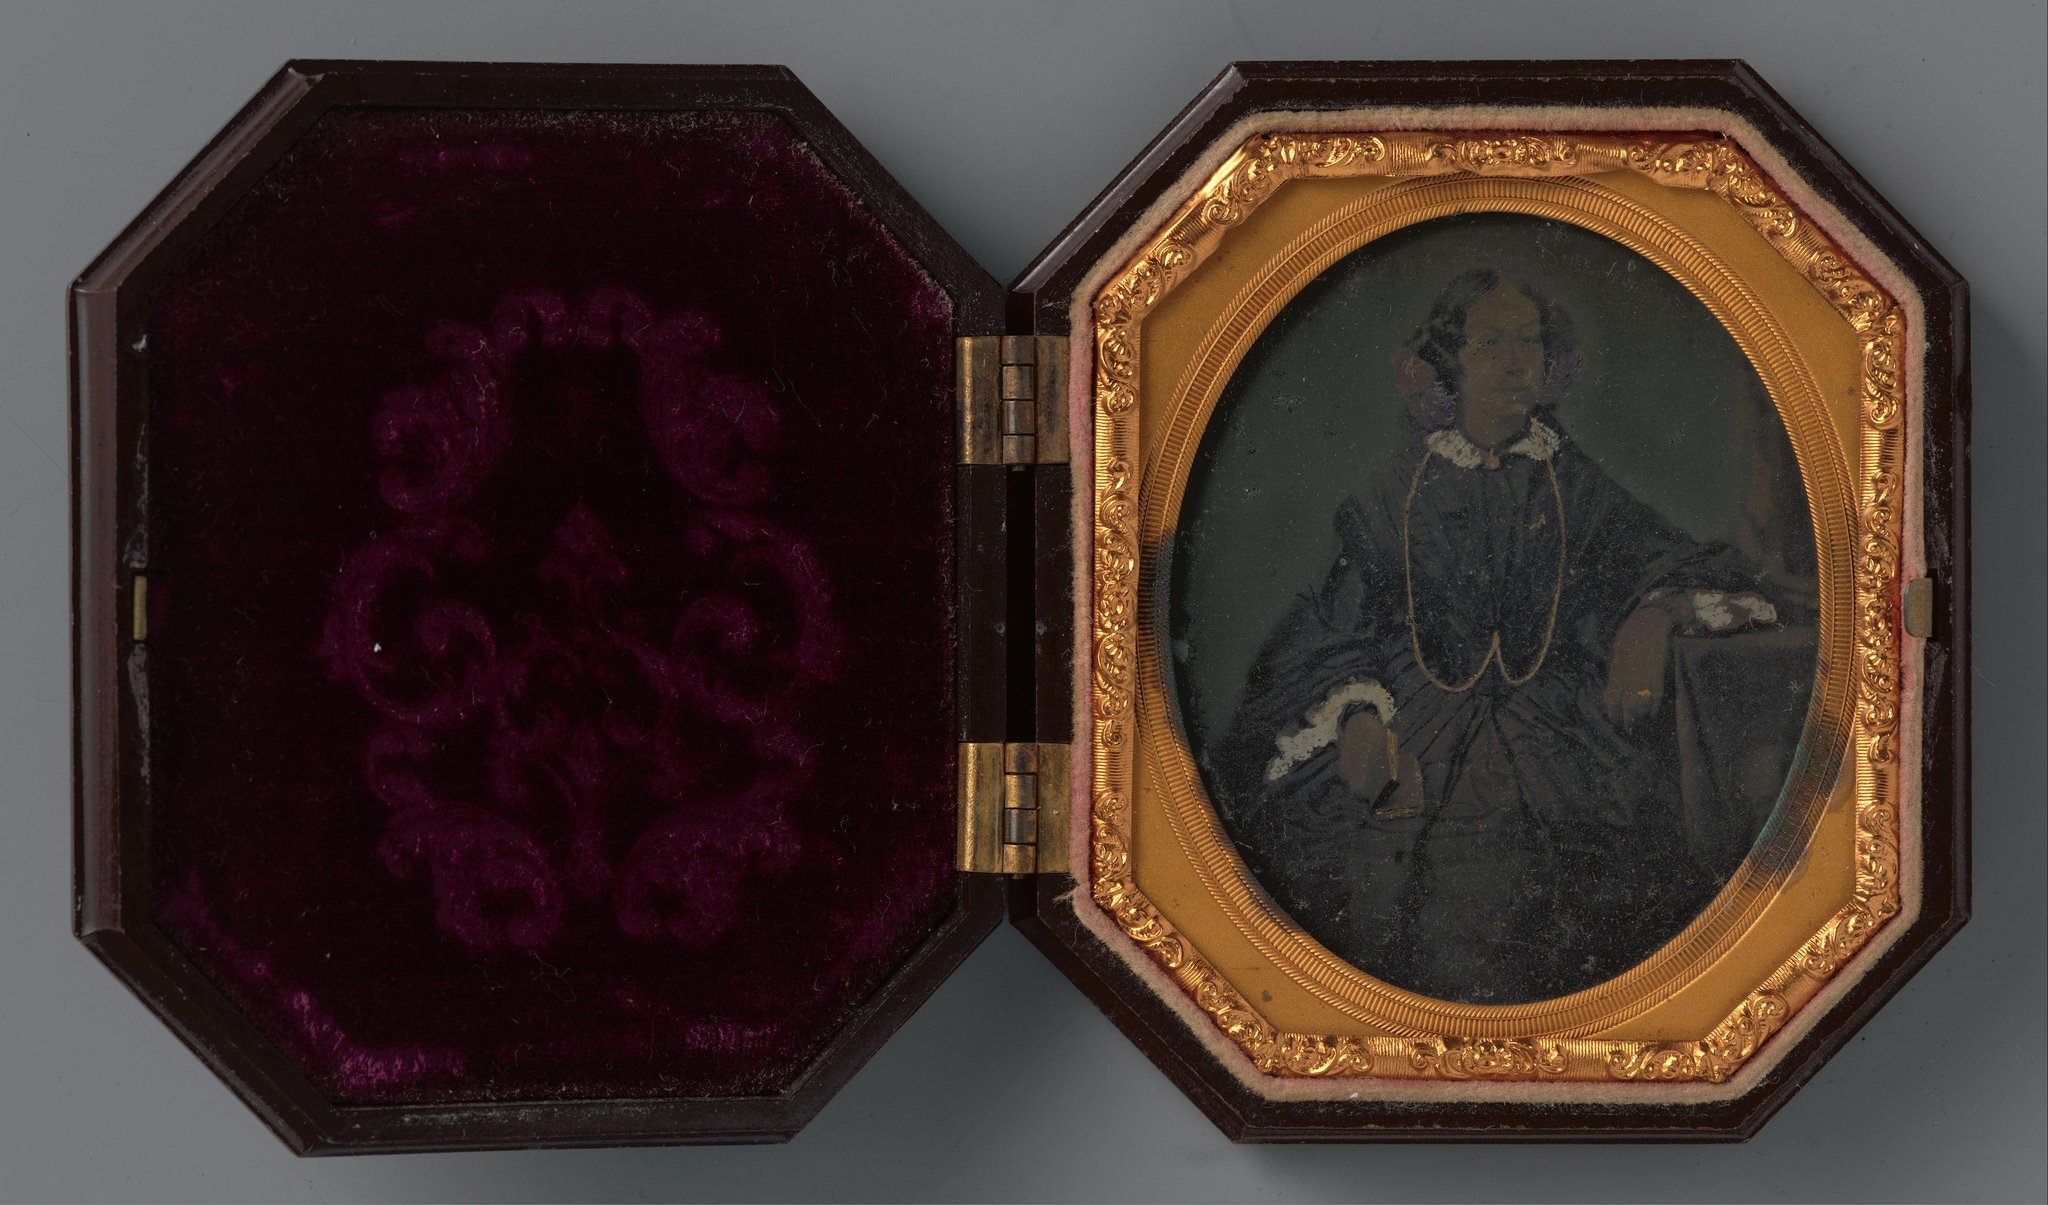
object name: photograph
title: Portret van een onbekende vrouw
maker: Anonymous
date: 1855-1870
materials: glass, metal, plastic, velvet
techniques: ambrotype, hand coloring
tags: sitting figure - aa - female human figure, historical persons - bb - woman